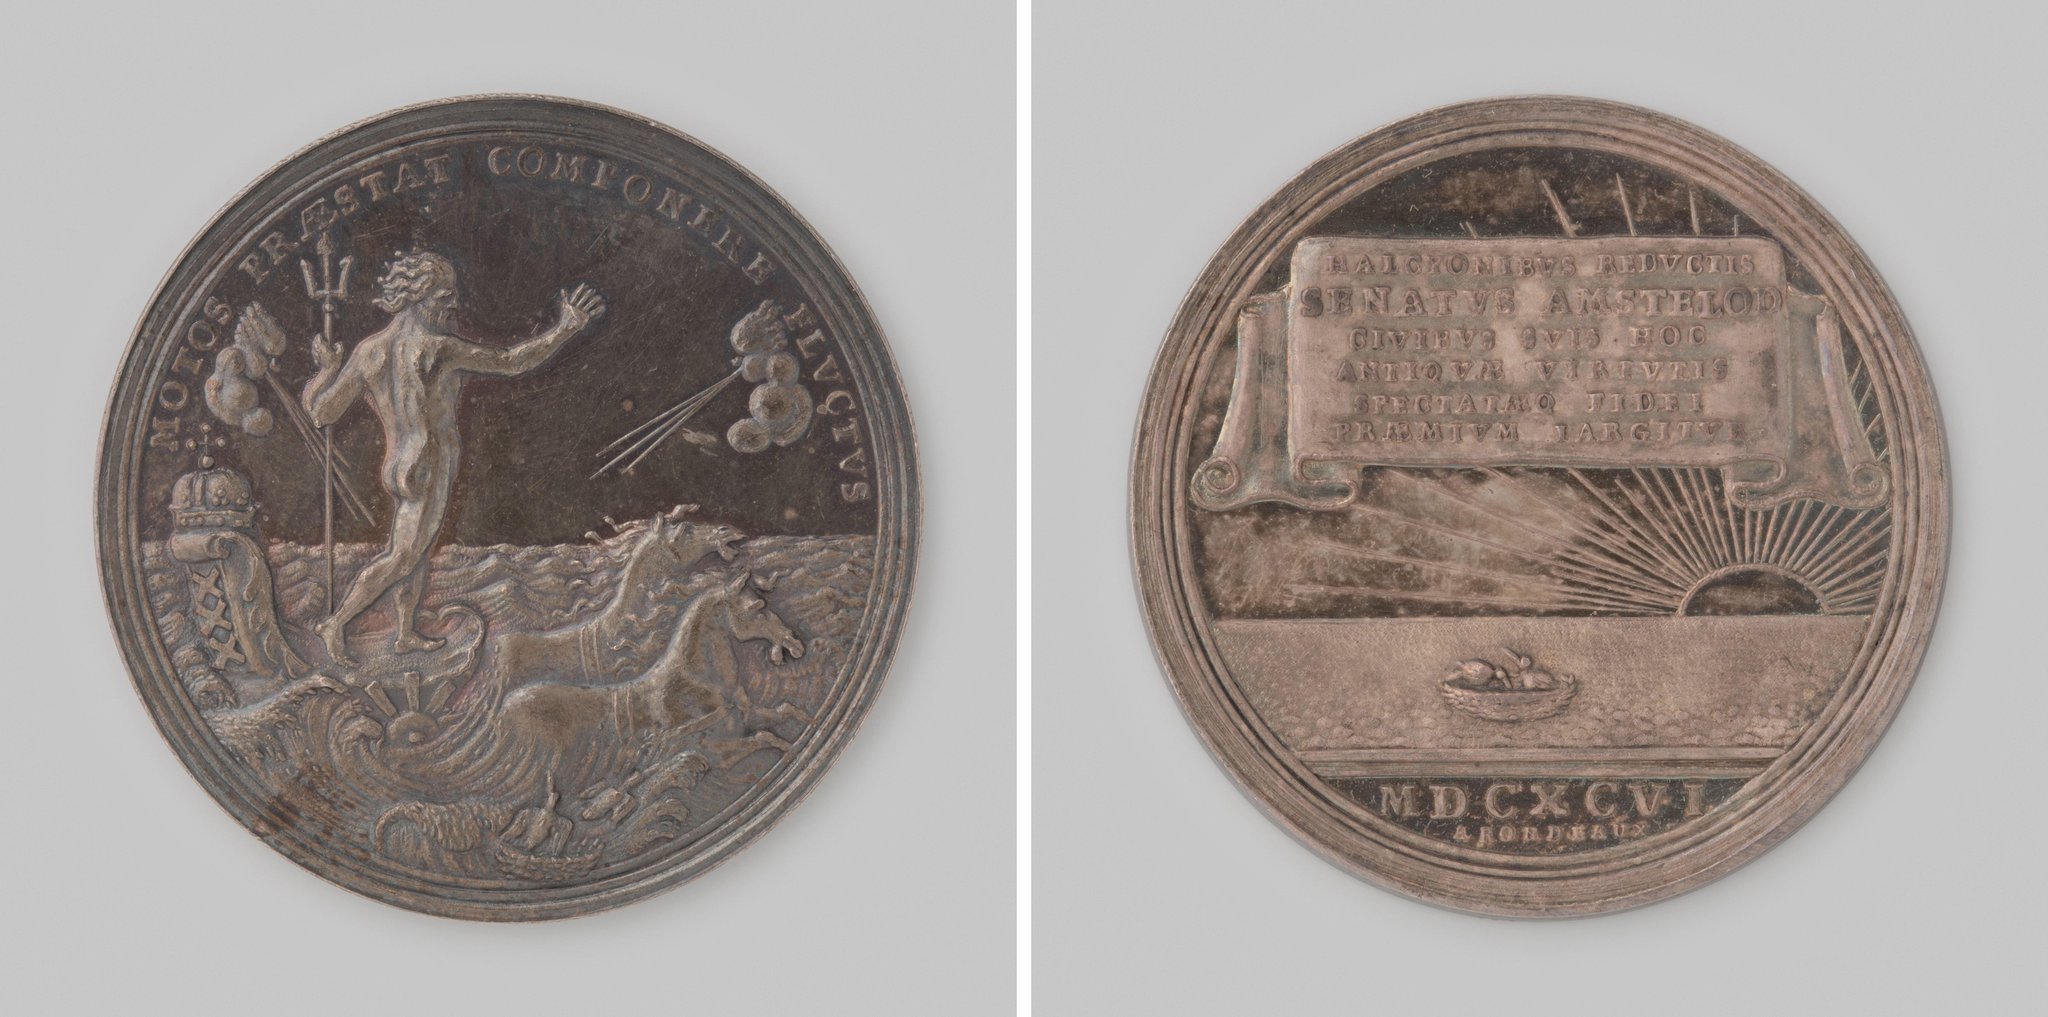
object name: history medal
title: Beloningspenning voor het neerslaan van het aansprekersoproer in Amsterdam 1696 (groot model)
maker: reynier arondeaux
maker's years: 1678-1727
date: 1696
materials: silver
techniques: striking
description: Zilveren penning, op de voorzijde Neptunus in strijdwagen op zee tussen twee windgoden, met omschrift, op de keerzijde een vredige zee waarop een vogelnest, met bovenaan een tekstvlag en in afsnede XDCXCVI / ARONDEAUX F